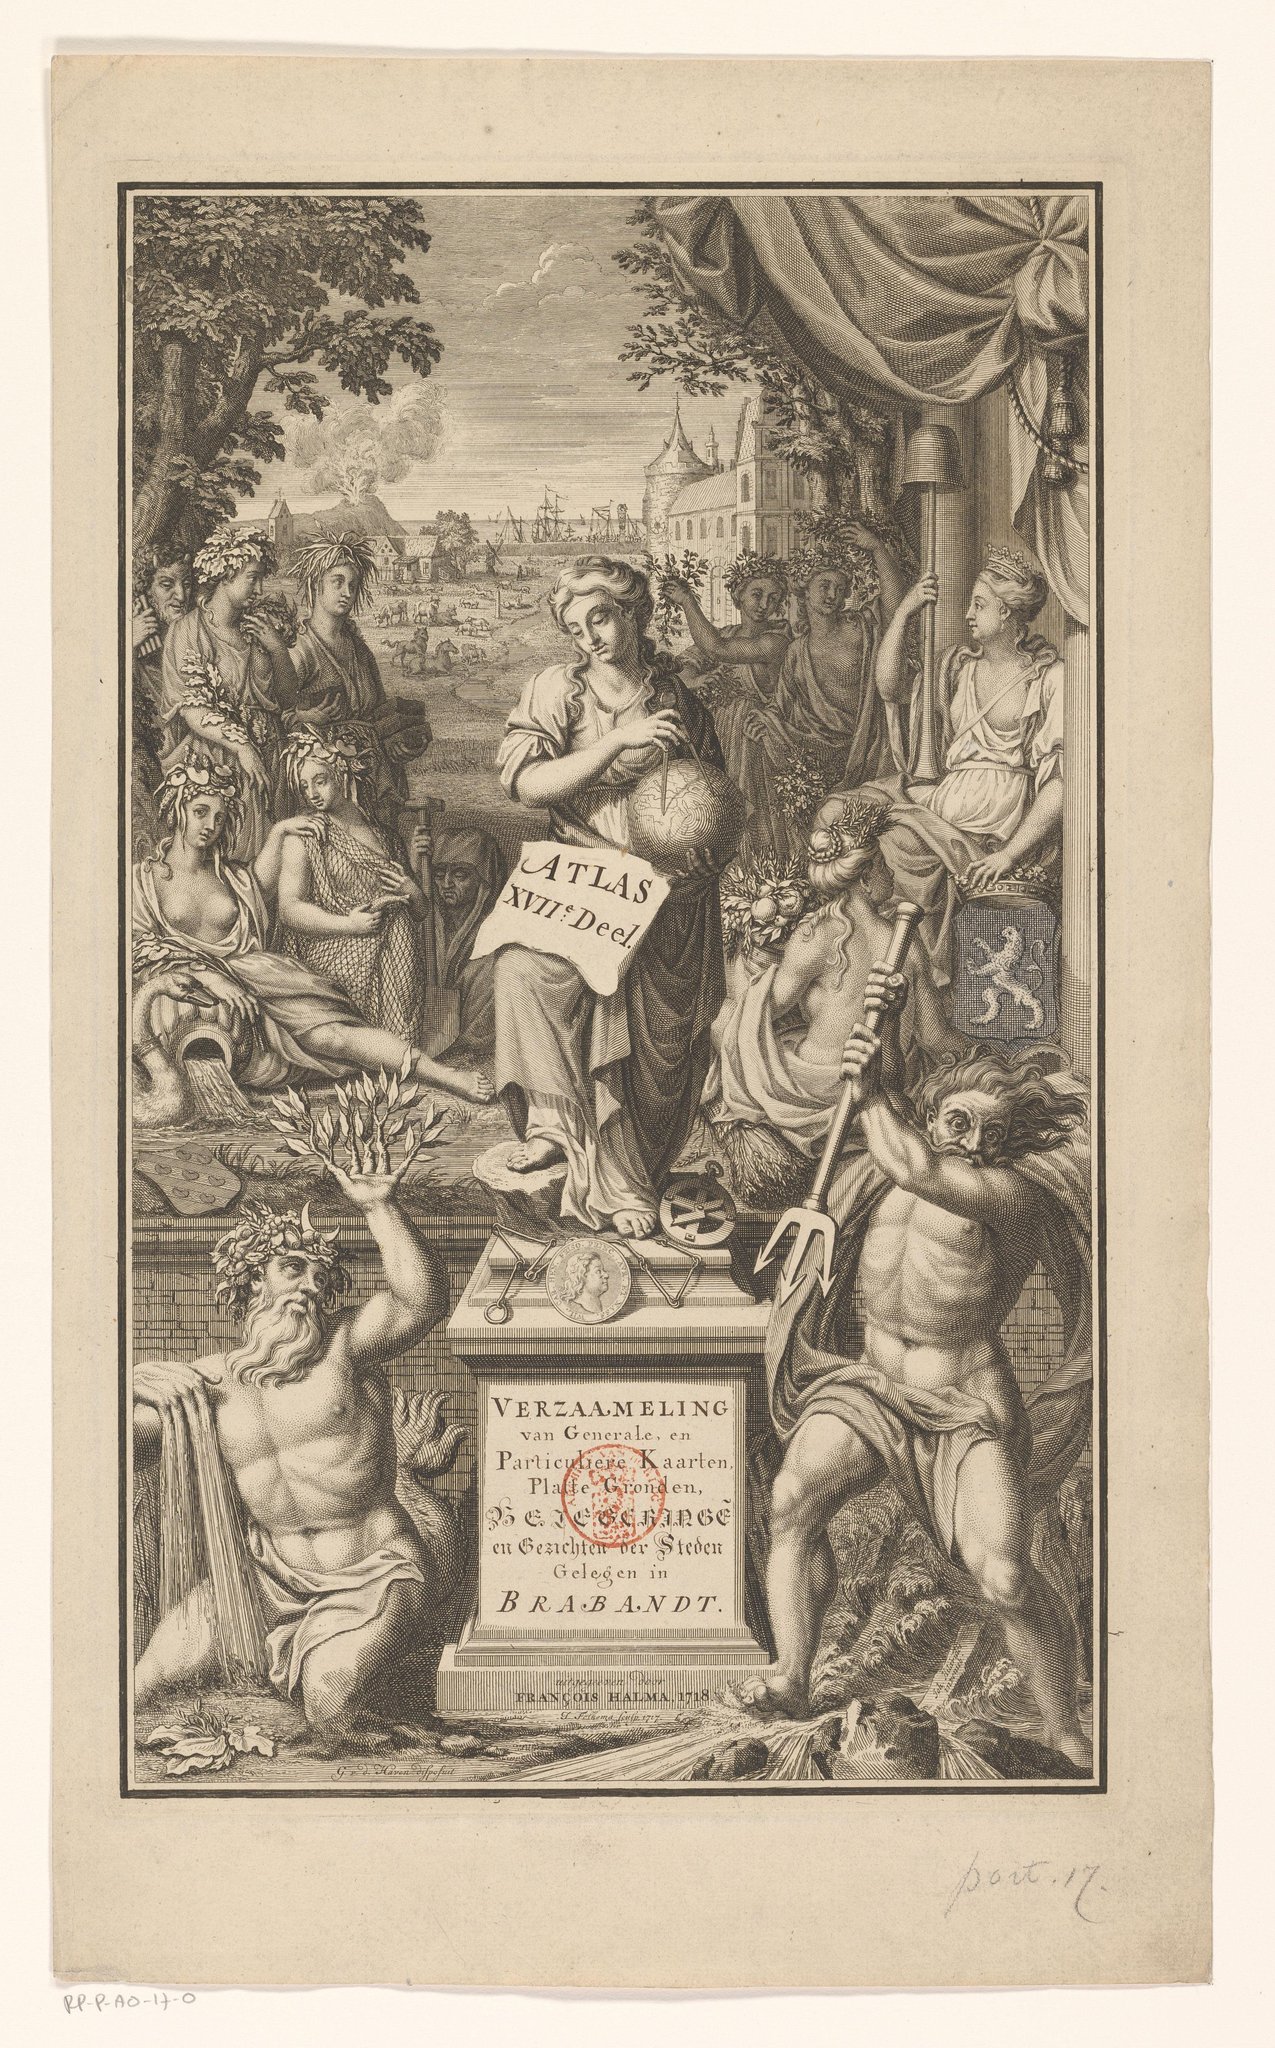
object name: print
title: Verzaameling van Generale, en Particuliere Kaarten, Platte Gronden, Belegeringe[n] en Gezichten der Steden Gelegen in Brabandt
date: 1717-1718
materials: ink, paper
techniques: engraving, etching, pen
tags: commercial fishery, (story of) ceres (demeter), peat-cutting, 'astronomia', 'cosmografia'; 'cosmografia' (ripa), personifications of countries, nations, states, districts, etc., river-gods, 'corografia', 'geografia', 'hidrografia' (ripa), agriculture, fruitfulness, productiveness, fertility, fecundity; 'fecondità' (ripa), (story of) flora, coat of arms (as symbol of the state, etc.) (+ province; provincial), neptune as lord of the sea, brabant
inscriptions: collector's mark: Lugt 19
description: Deze prent is hier gebruikt als titelprent van een deel van een ongebonden atlas; een verzameling cartografische en topografische prenten en tekeningen. Oorspronkelijk was de prent echter bedoeld als titelpagina voor een gebonden atlas met kaarten van Friesland, waardoor een deel van de hier volgende beschrijving betrekking heeft op die context. Op het voetstuk in het midden staat de personificatie van de cartografie, met in haar hand een aardbol die ze met een passer meet. Op haar bovenbeen rust een blad met het handgeschreven deel van de atlas (oorspronkelijk een kaart van Friesland). Aan haar voeten een meetketting, een rond (land)meetkundig instrument en een portret van Willem IV van Oranje-Nassau. Daaronder de handgeschreven titel van dit deel van de atlas. Ze houdt een wakend oog op Wispelturigheid (Wispeltuer), linksonder. Oorspronkelijk staat hij voor de wispelturigheid waar het Friese land zich naar moest schikken: een bos kon opeens onder water staan, want zijn lichaam smelt door het zoute water van de zee. Linksboven zijn hoofd een wapenschild met het wapen van Friesland (met schuinbalken en pompeblêden). De dreiging van de zee is rechtsonder verbeeld door een onstuimige Neptunus (Zeevoogd). Links en rechts van Cartografie nog meer figuren die oorspronkelijk betrekking hadden op Friesland en haar vruchtbare natuur, visserij en landbouw. Links, met haar arm leunend op een kruik waar water uitstroomt, een stroomgodin (Stroomvoogdess) met rechts van haar de personificatie van de visserij (Visschevang). Boven hen van links naar rechts: een sater met fluit als personificatie van de natuur (Natuer), de personificatie van de bossen met eikenloven (Woudman) en personificatie van de turfwinning (vrouw Veenbrand). Rechtsonder haar vrouw Onland, die rouwt om de schade die de turfwinning aan het land veroorzaakt. Rechts van Cartografie zit Flora en/of Ceres (vrouw Veldgewas) met korenaren en cornucopia, ze staat voor de overvloed die voortvloeit uit het land. Boven haar, op de achtergrond, twee vrouwelijke personificaties die in verband staan met groene weides en/of grasvelden: Beemdeheil en Graazevol. Rechts, met in haar ene hand een bazuin met daarop een vrijheidshoed en in de andere hand een schild met het wapen van Brabant, de personificatie van het gebied van dit deel van de atlas (oorspronkelijk de Friese Maagd met het provinciewapen met twee leeuwen). Op de achtergrond een landschap met kenmerkende Friese elementen, zoals het Sjaerdemaslot te Franeker en de vuurspuwende Rode Klif te Gaasterland (zou in de oudheid een vulkaan zijn geweest).